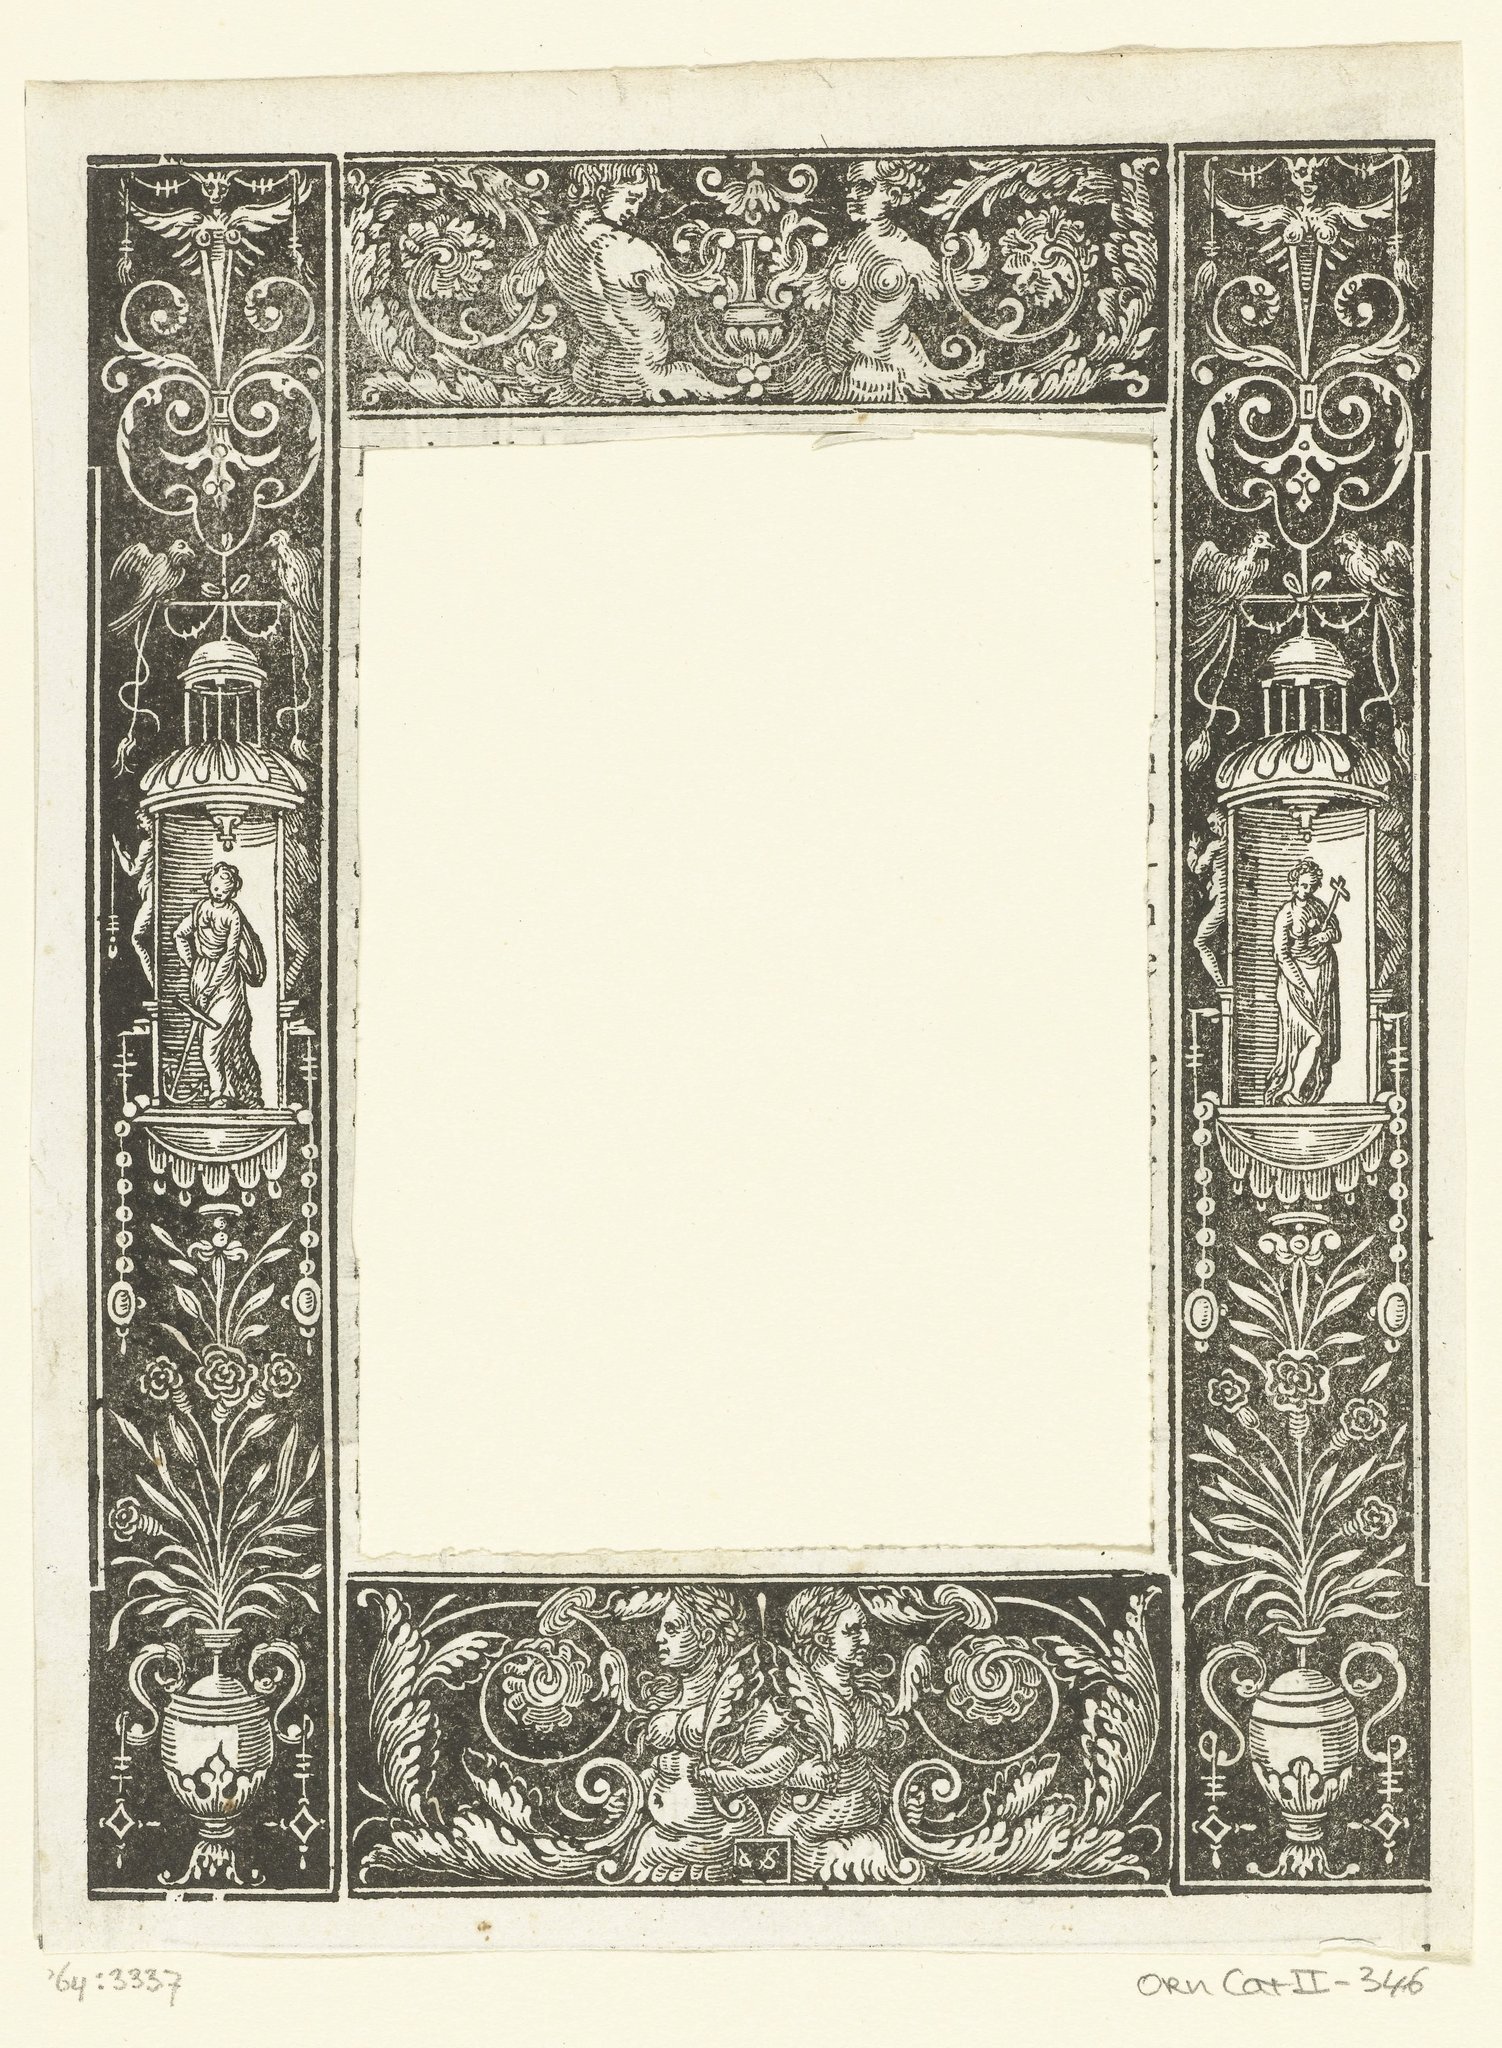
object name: ornament print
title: Lijsten met bladranken, kandelabermotieven, vazen met bloemen en bloemen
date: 1646-1657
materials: paper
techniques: woodcut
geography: amsterdam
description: Omlijsting gedrukt van vier houtblokken. Op beide panelen staat onderaan een bloemenvaas, daarboven staat Hoop of Geloof in een nis. De lijsten zijn grotendeels varianten of kopieën naar laat zestiende eeuwse Franse en Vlaamse prenten. Alle omlijstingen werden gebruikt om een Bijbel te illustreren.